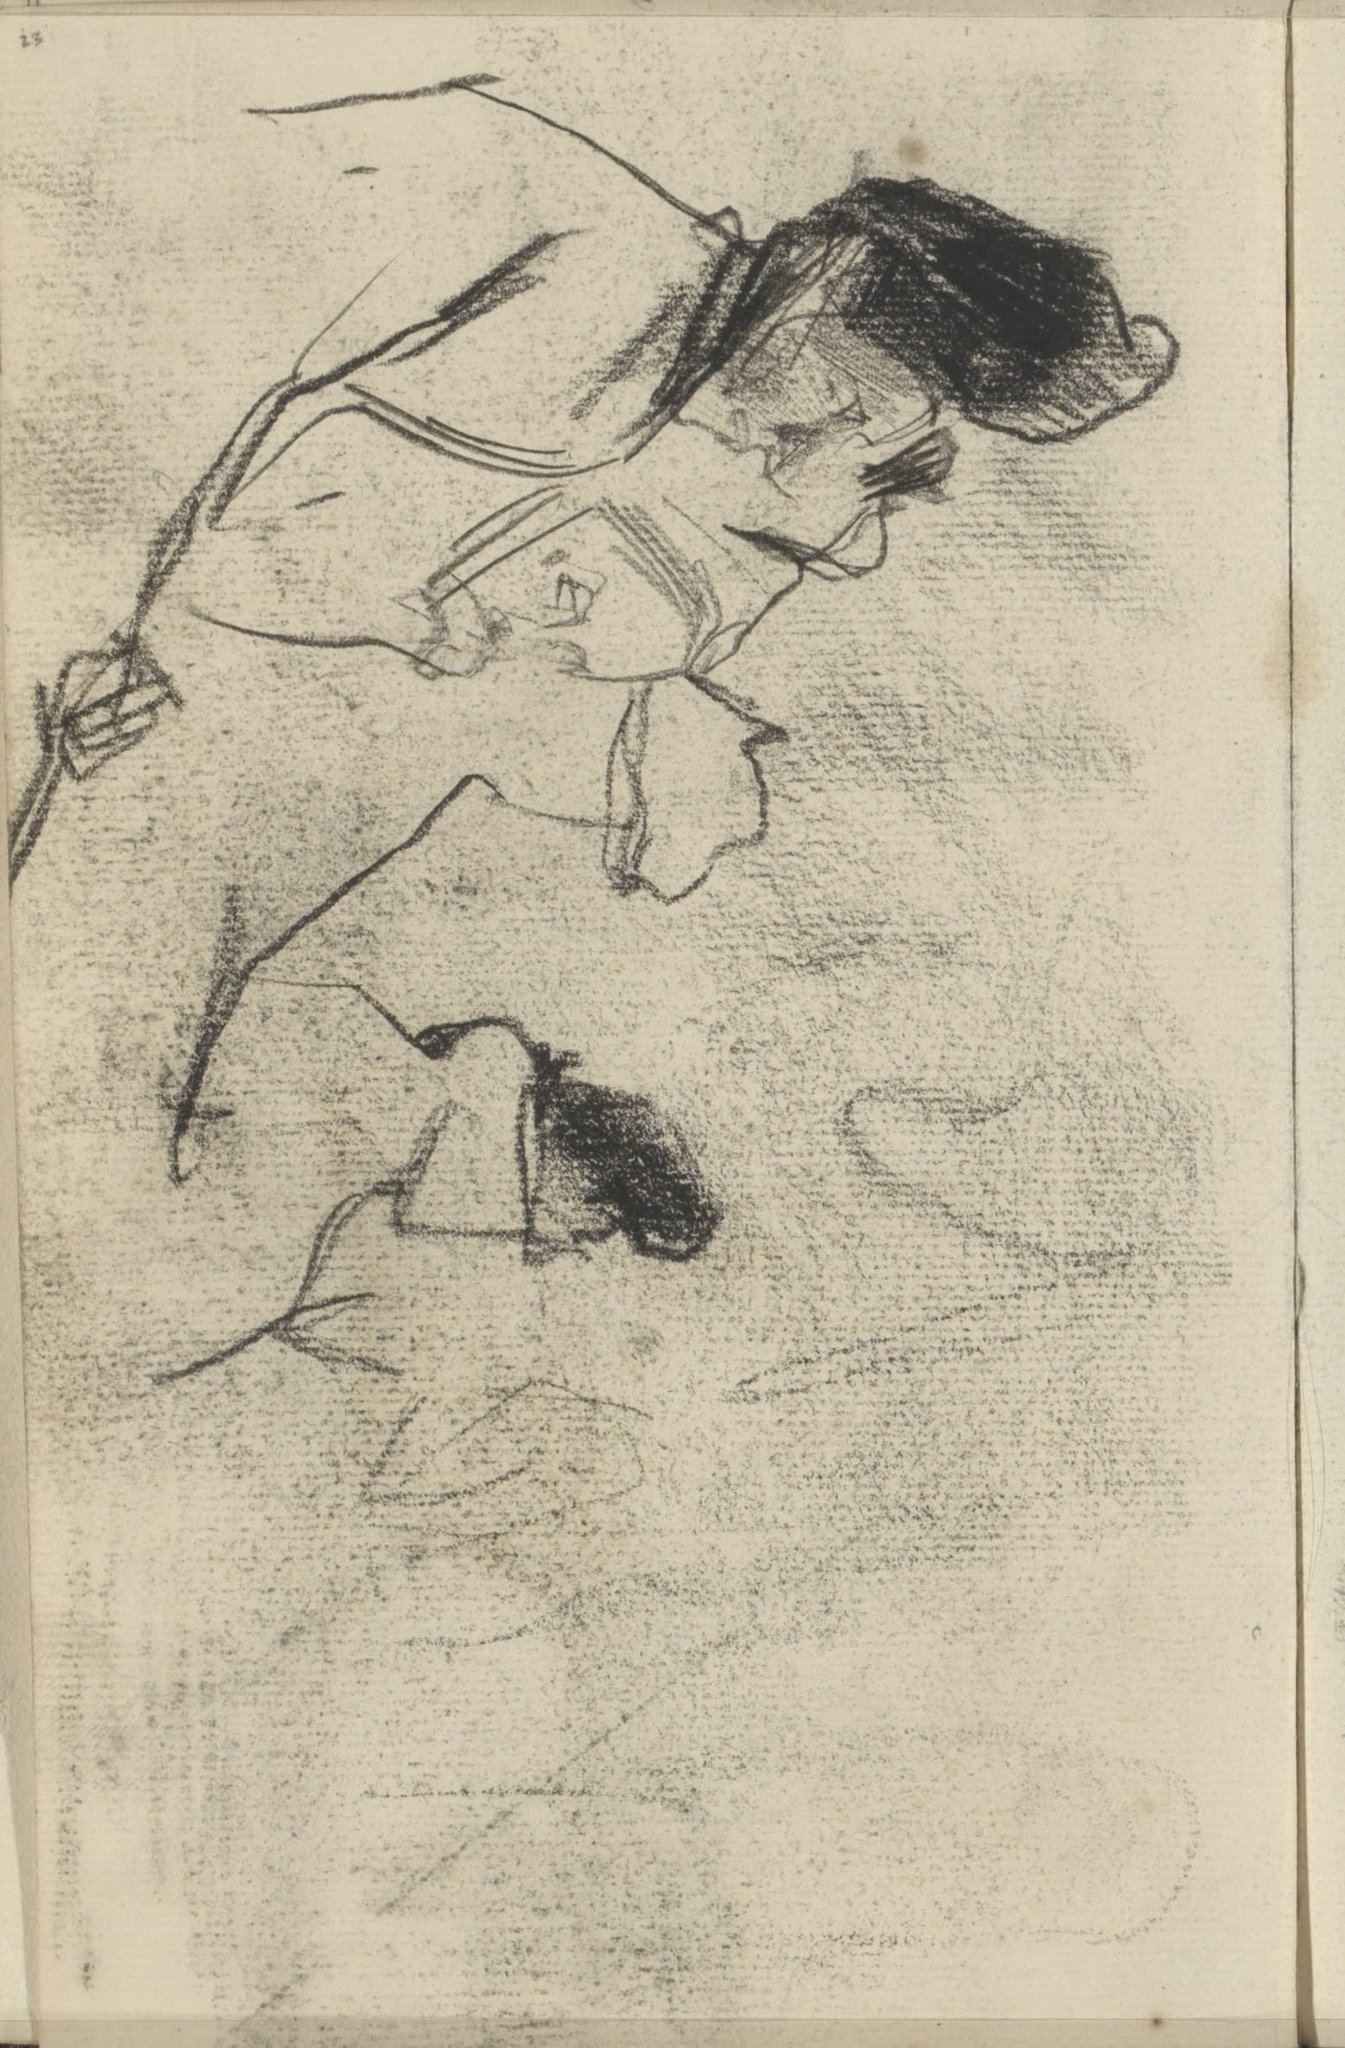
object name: sketchbook leaf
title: Vrouwen met hoed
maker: george hendrik breitner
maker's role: draughtsman, painter, print maker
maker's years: 1857-1923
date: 1886-1898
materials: chalk, paper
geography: amsterdam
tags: adult woman, head-gear: hat (+ women's clothes)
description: Pagina 23 uit een schetsboek met 18 bladen.